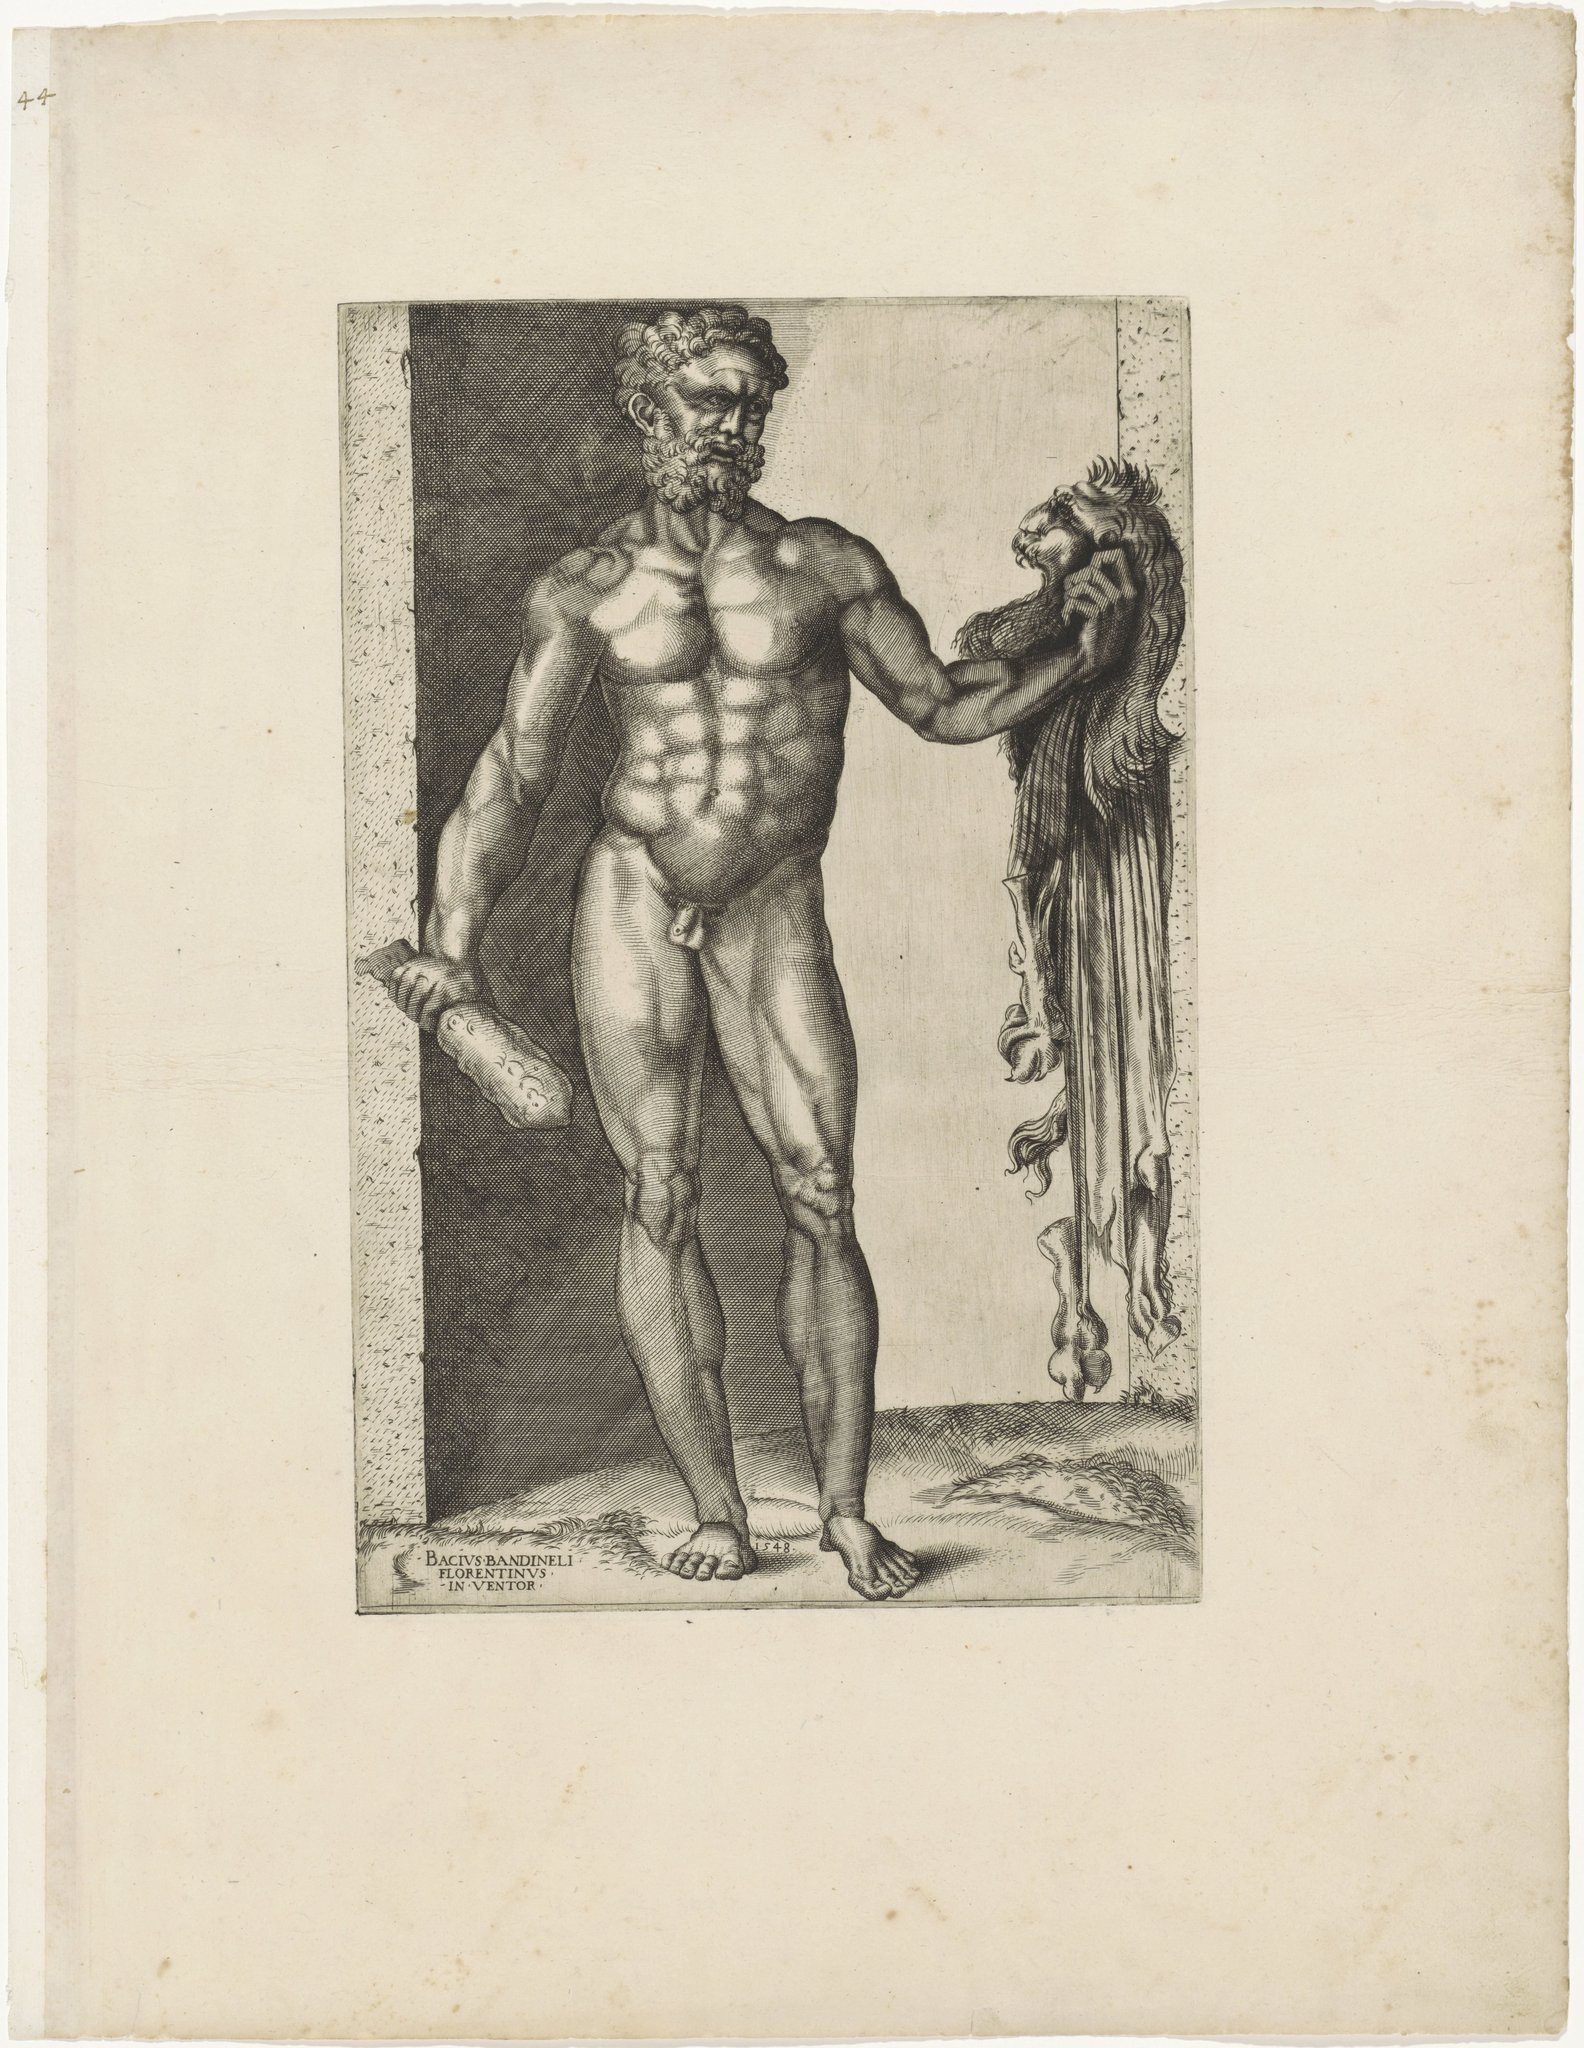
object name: album leaf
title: Hercules with the Head of the Nemean Lion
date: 1548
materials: paper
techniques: engraving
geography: florence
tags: (1) hercules chokes the nemean lion with his arms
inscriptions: number: ‘44’, collector's mark: Lugt 2760, collector's mark: Lugt 2228, watermark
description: Sheets from the dismantled Zobel Album occasionally surface on the market. They can be recognized by their format and the number written in the upper left corner. In 2011, the Rijksmuseum acquired this exceptionally rare engraving of the muscular demigod Hercules holding his club in one hand and the skin of the Nemean lion in the other.